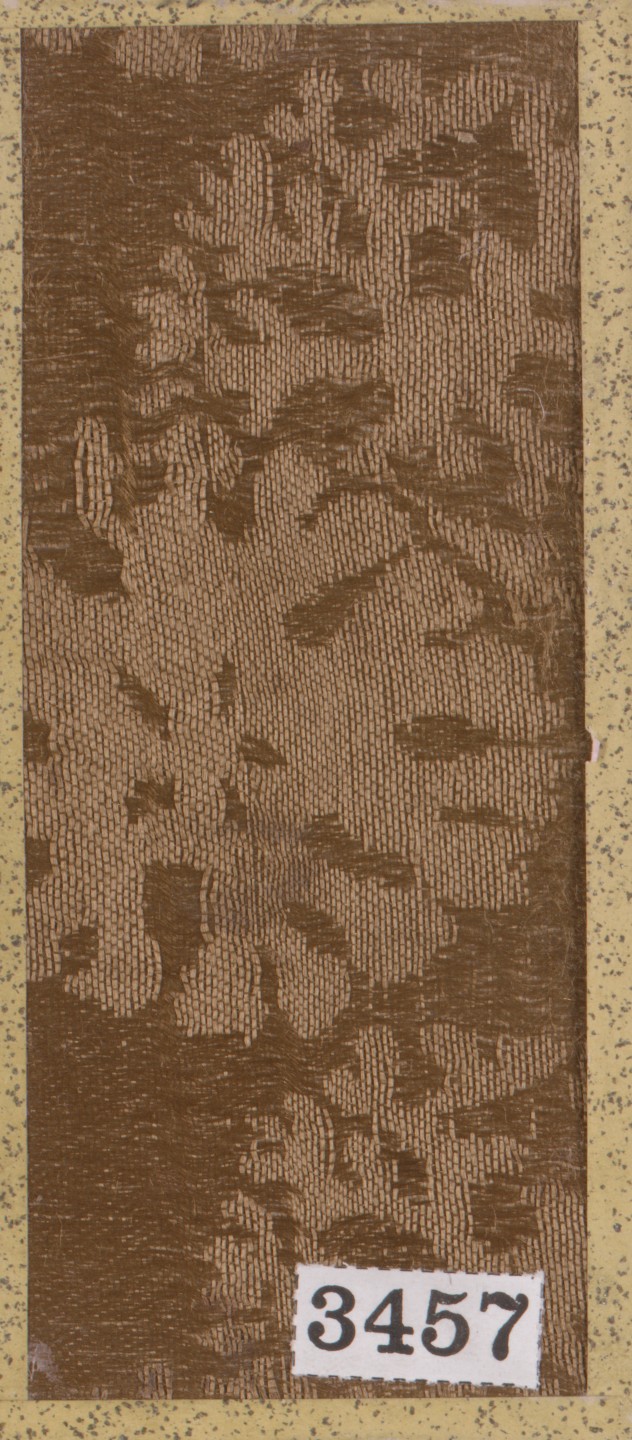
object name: sample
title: Textile Sample from Sample Book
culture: japanese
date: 1801-1900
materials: silk